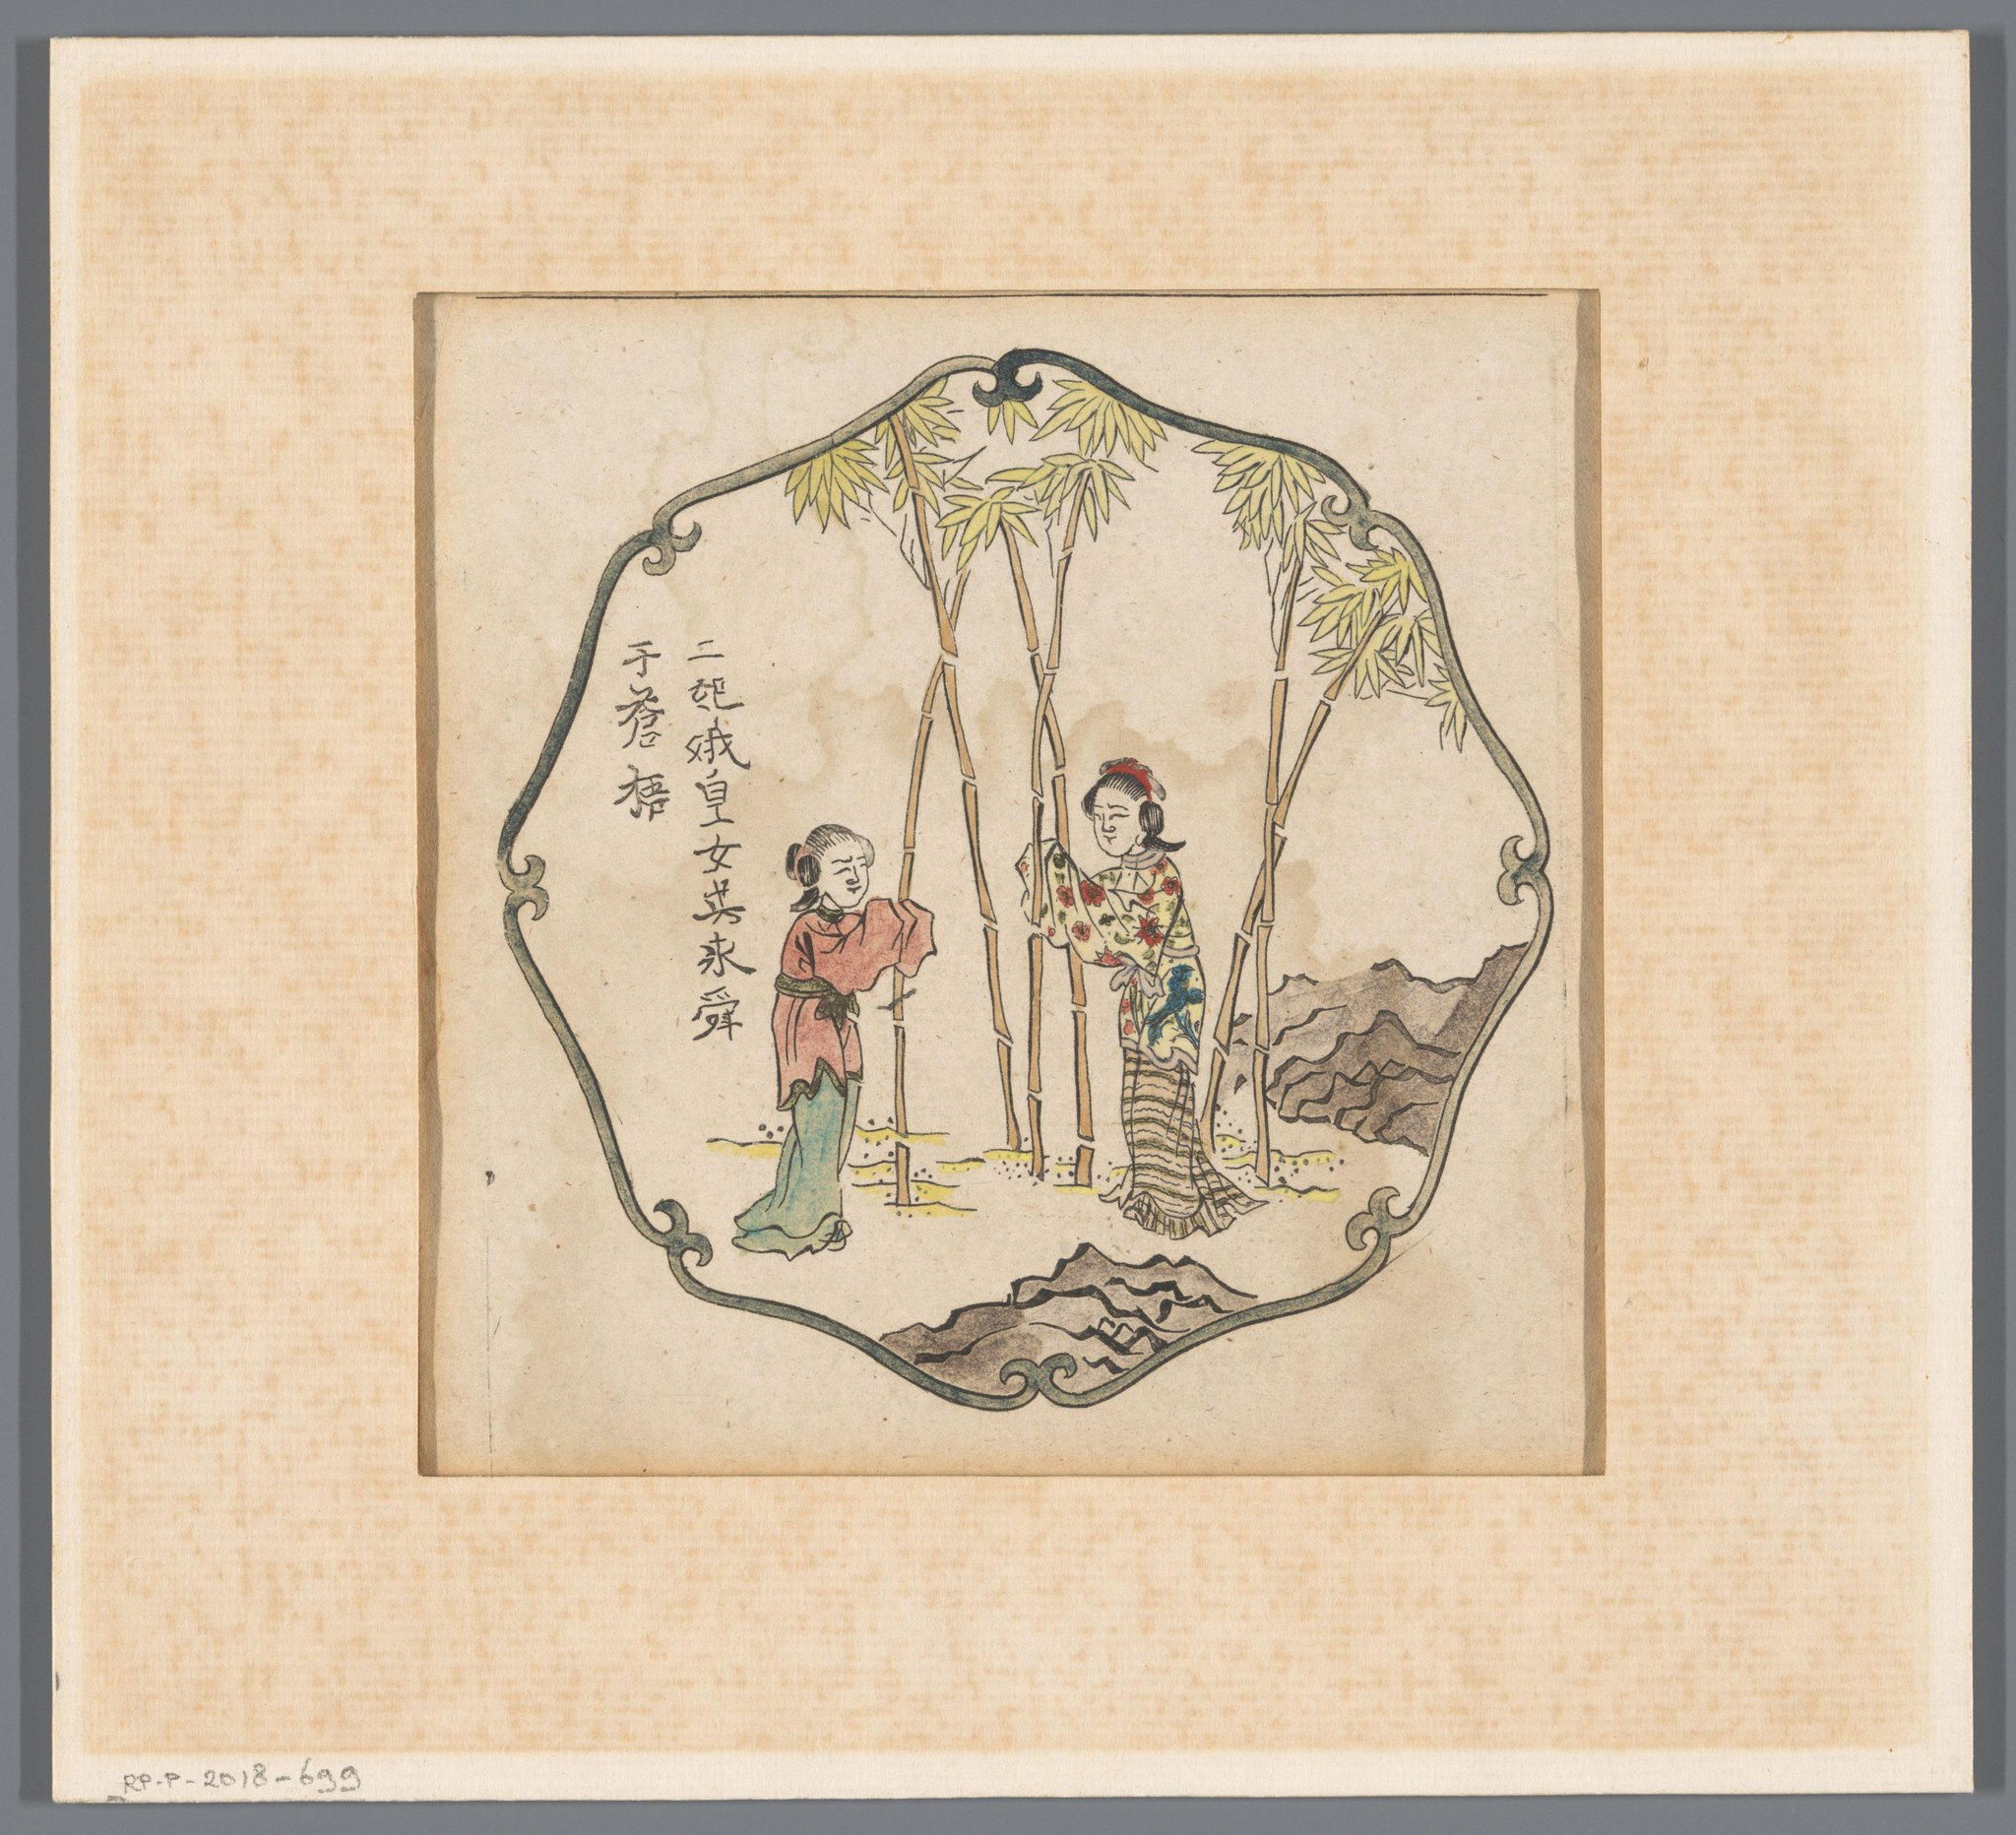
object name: print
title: Picturae Sinicae Ac Surattenae, Vasis Tabellisque exhibitae, Admiranda; colligente Petro Schenkio cum privil: Amstelaed: 1702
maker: pieter schenk (i)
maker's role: print maker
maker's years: 1660-1711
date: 1702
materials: paper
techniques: etching, hand coloring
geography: amsterdam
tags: chinese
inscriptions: collector's mark: Lugt 2228, collector's mark: Lugt 2760